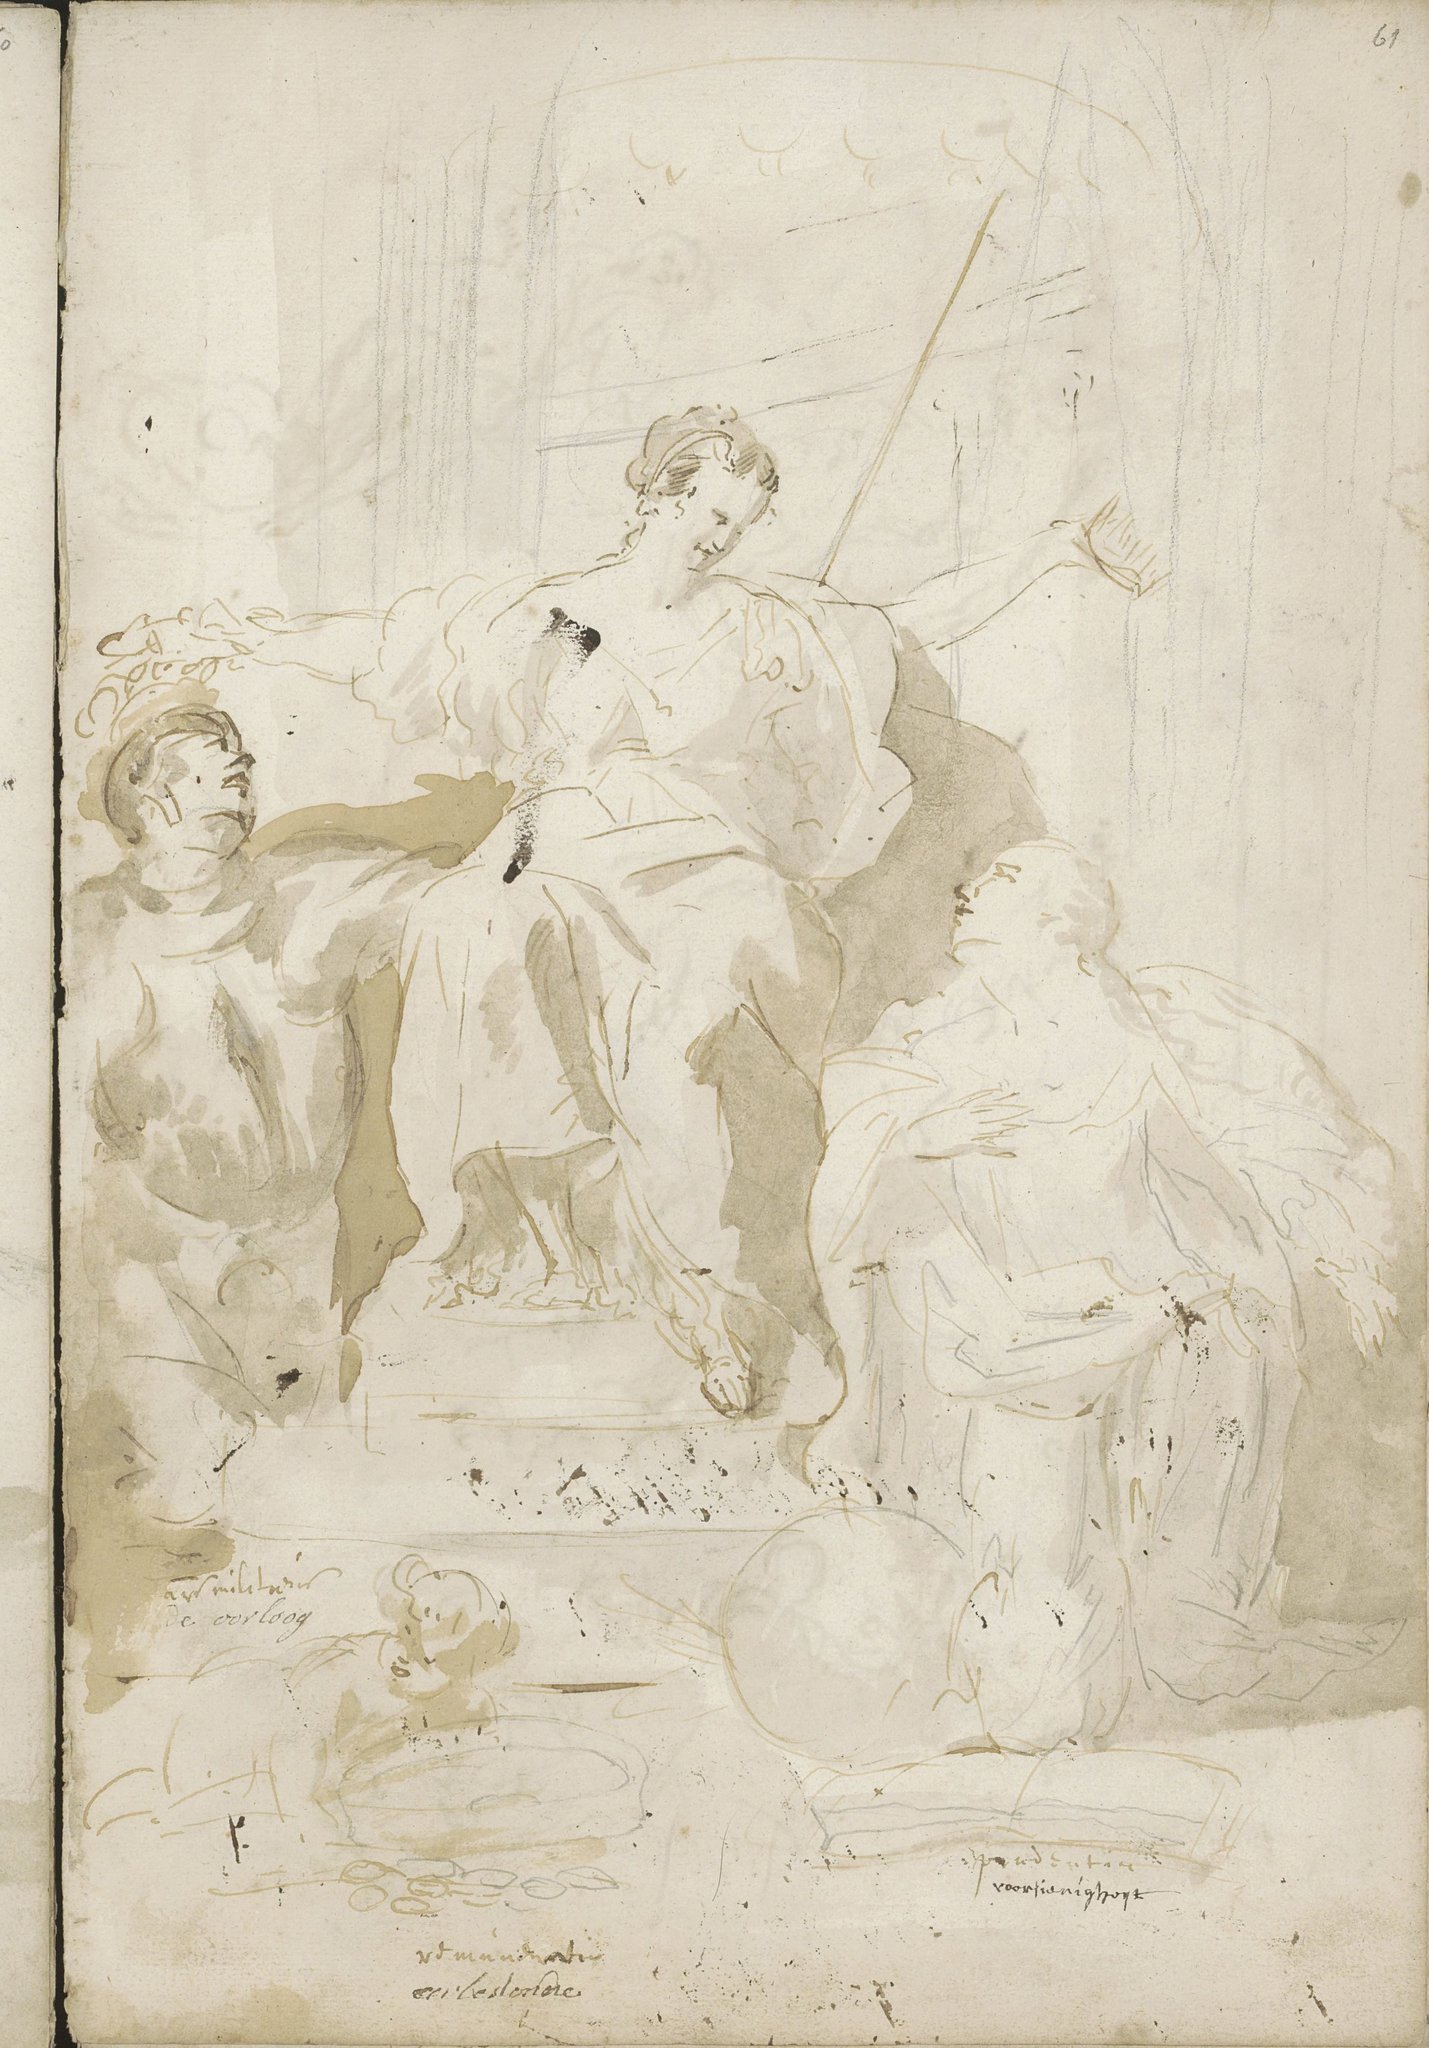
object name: sketchbook leaf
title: Allegorische voorstelling met Oorlog en Voorzienigheid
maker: Anonymous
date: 1650-1799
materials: ink, paper, pencil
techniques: brush, pen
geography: italy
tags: forethought, deliberation; 'previdenza', 'providenza' (ripa)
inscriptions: annotation: ‘[...] militari[...]/ de oorlog/ [...]/ [...]eston[...]/ prudentae/ voorzienigheyt’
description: Een vrouw zittende op een sokkel met uitgespreide armen legt een lauwerkrans op het hoofd van de personificatie van Oorlog. Naast haar knielt de personificatie van de Voorzienigheid. Naast haar liggen een wereldbol en open boek. Bladzijde 61 uit een schetsboek met 72 bladzijden.